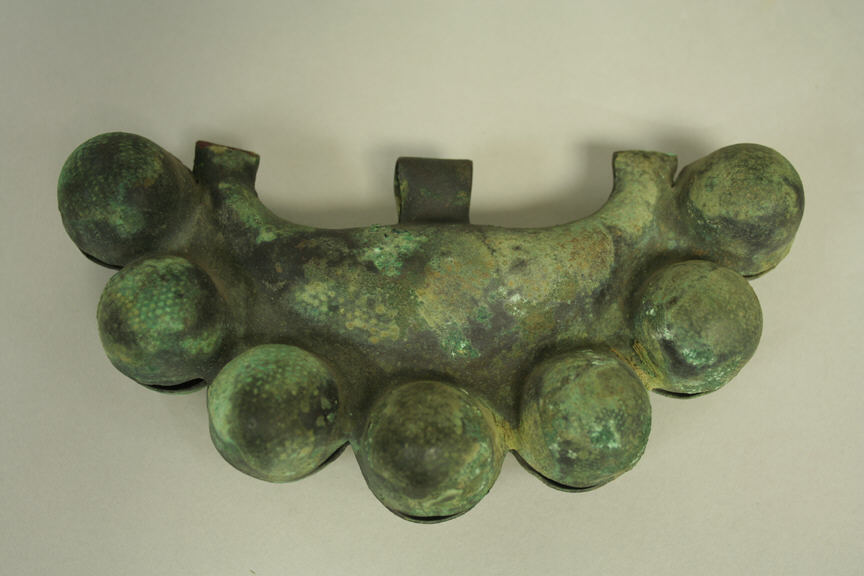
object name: belt ornament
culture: moche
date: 101-700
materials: copper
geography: peru